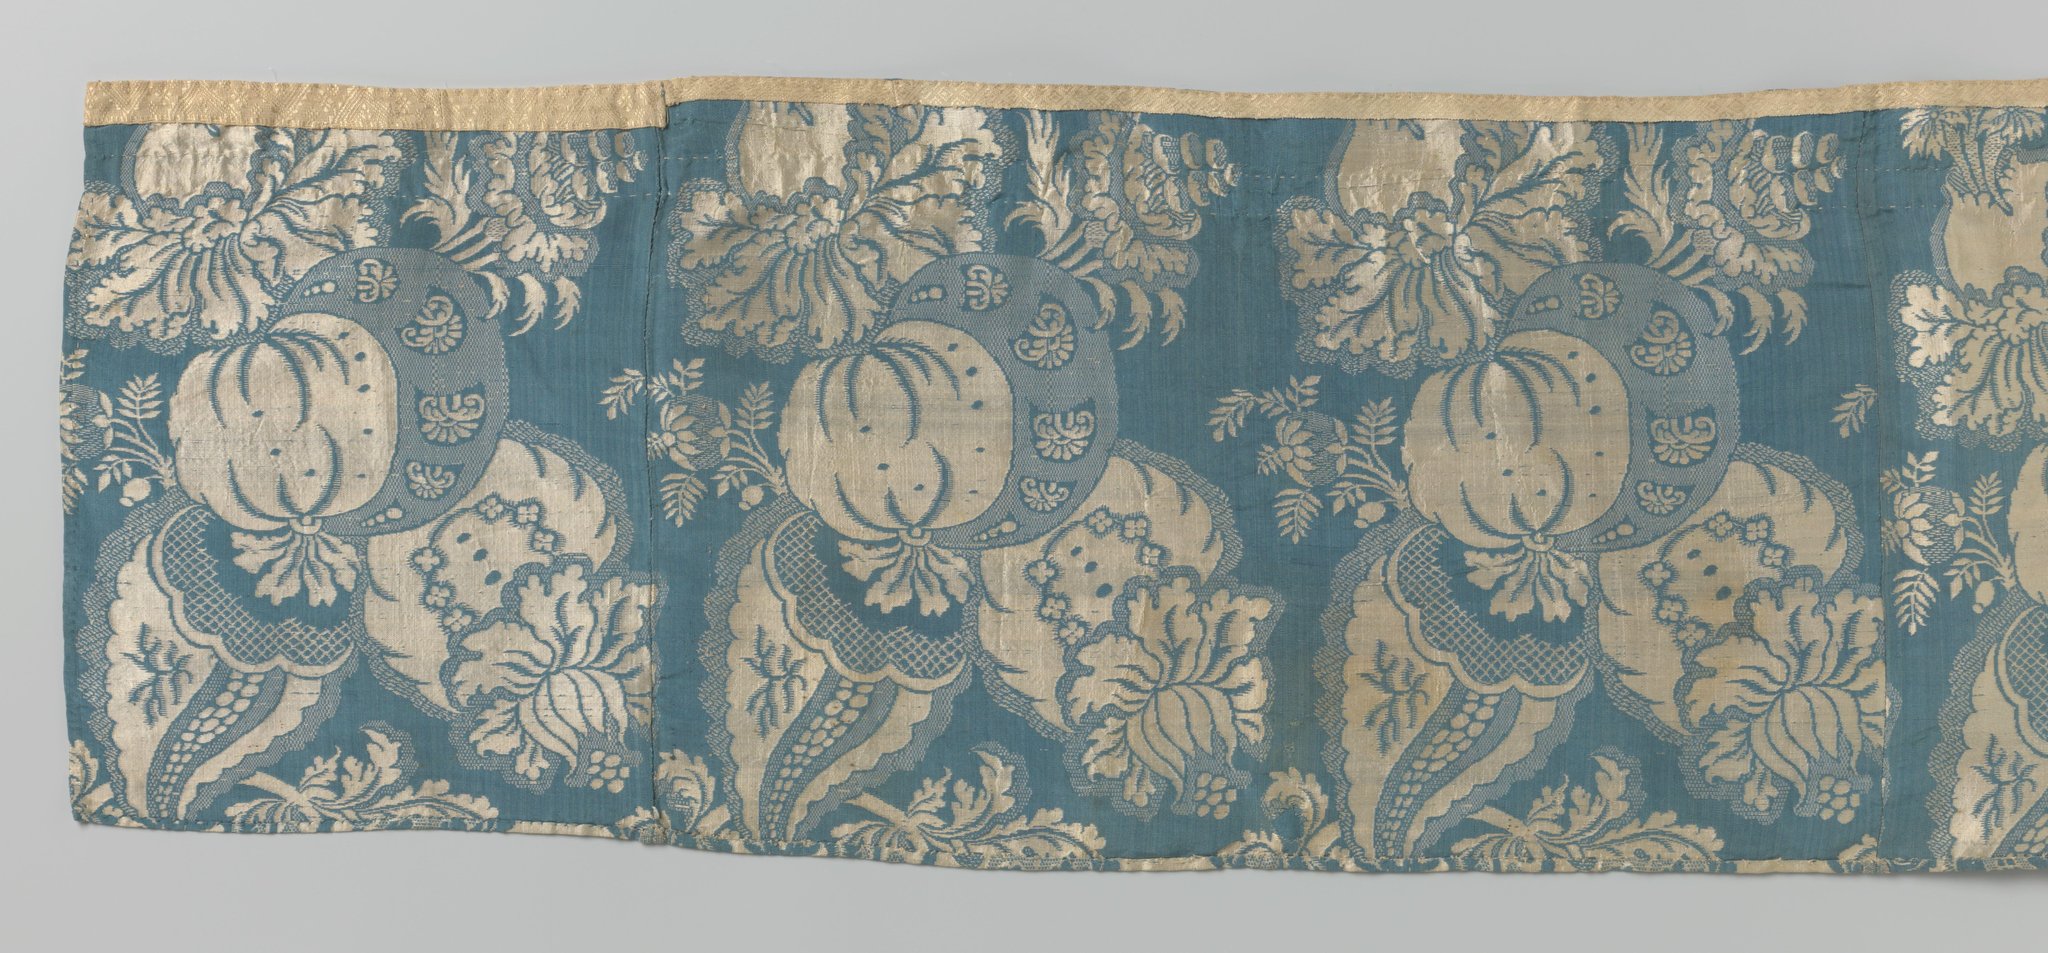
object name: silk textile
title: Fragment van een zijdeweefsel met een patroon van een fors boeket en granaatappel in wit op blauw, een zogenaamd mozaïekdecor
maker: Anonymous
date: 1700-1725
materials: silk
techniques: weave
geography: france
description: Fragment van een zijdeweefsel met een lopend patroon van zeer grote bloemen en een vrucht. Een boeket is om een hangende granaatappel gerangschikt. Linksonder een peervormig blad met gelobde contouren en mozaïekranden en nerf. Rechtsonder een losse bloem, linksboven een papaver met grote zaadbol als hart en rechtsboven drie uitschuivende bloemen. Onder het blad een gebogen bloemtak op een schuin afgesneden verbrede voet. Opmerking: fragment bekleding (?) van een "wangenstoel".